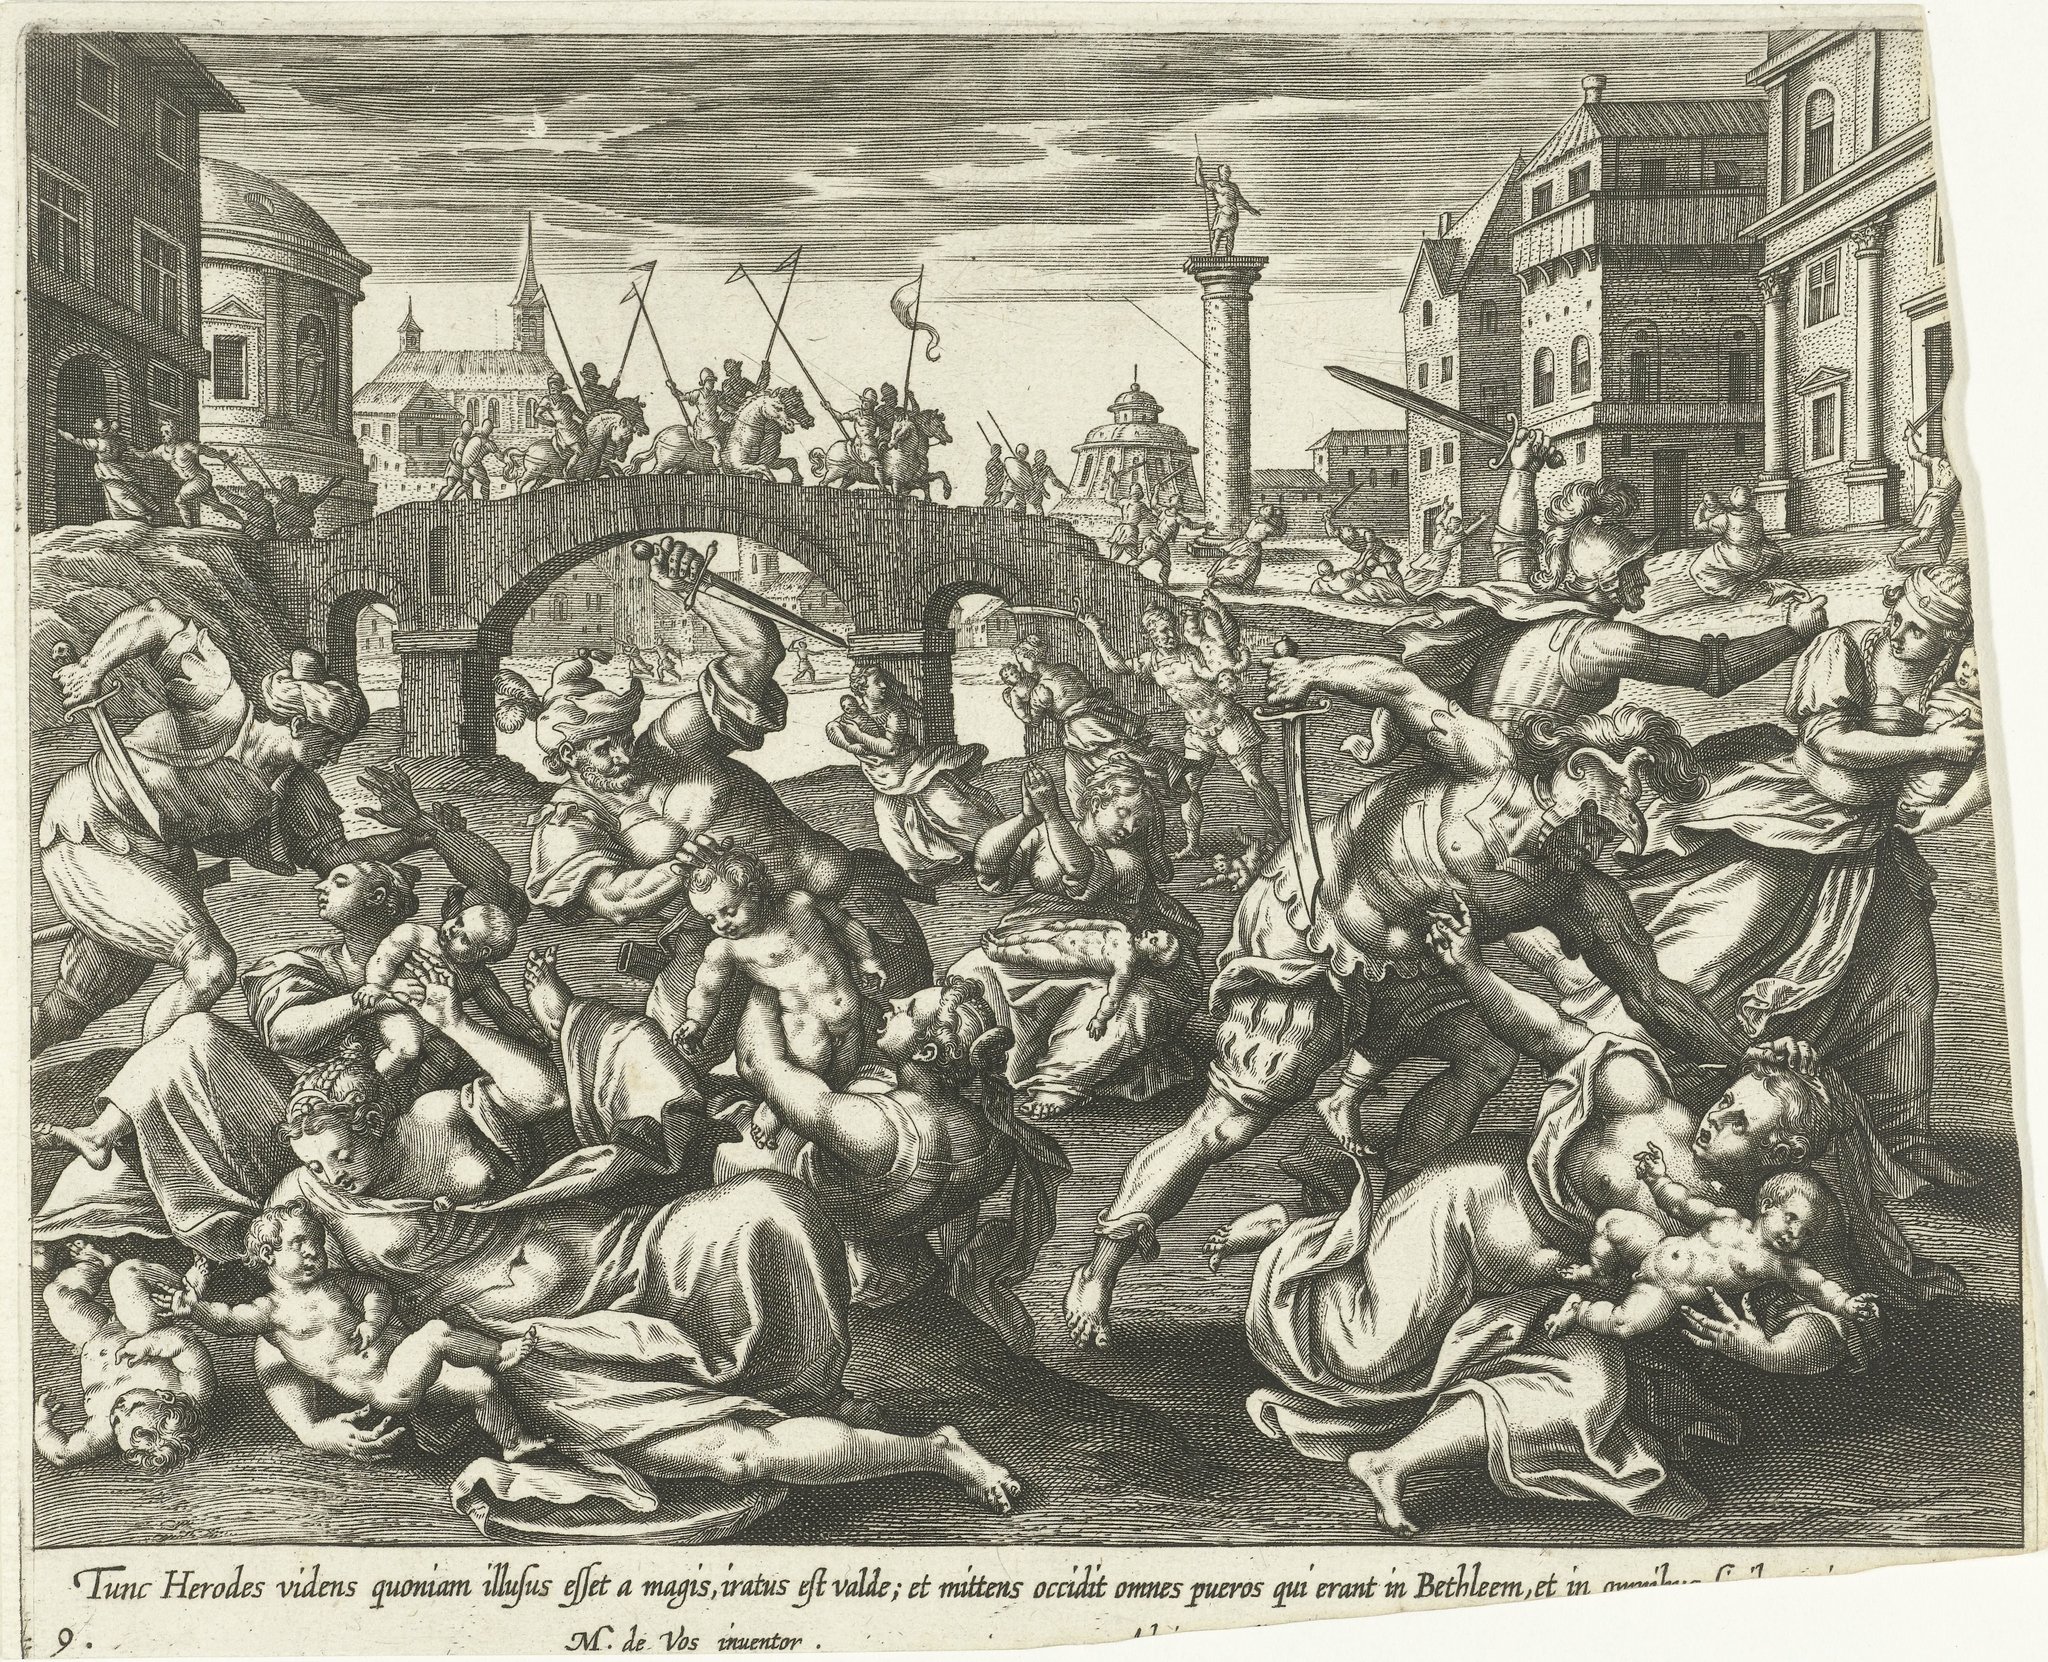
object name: print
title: Leven, passie en wederopstanding van Christus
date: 1598-1618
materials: paper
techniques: engraving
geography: antwerp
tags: the massacre ot the innocents; sometimes herod looking on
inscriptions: collector's mark: Lugt 2228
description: Moeders proberen hun kinderen te beschermen tegen de soldaten van Herodes. Zij hebben de opdracht gekregen alle jongens van twee jaar en jonger in Betlehem te vermoorden (Matteüs 2:16). De prent heeft een Latijns onderschrift. De prent maakt deel uit van een serie over het leven van Christus.